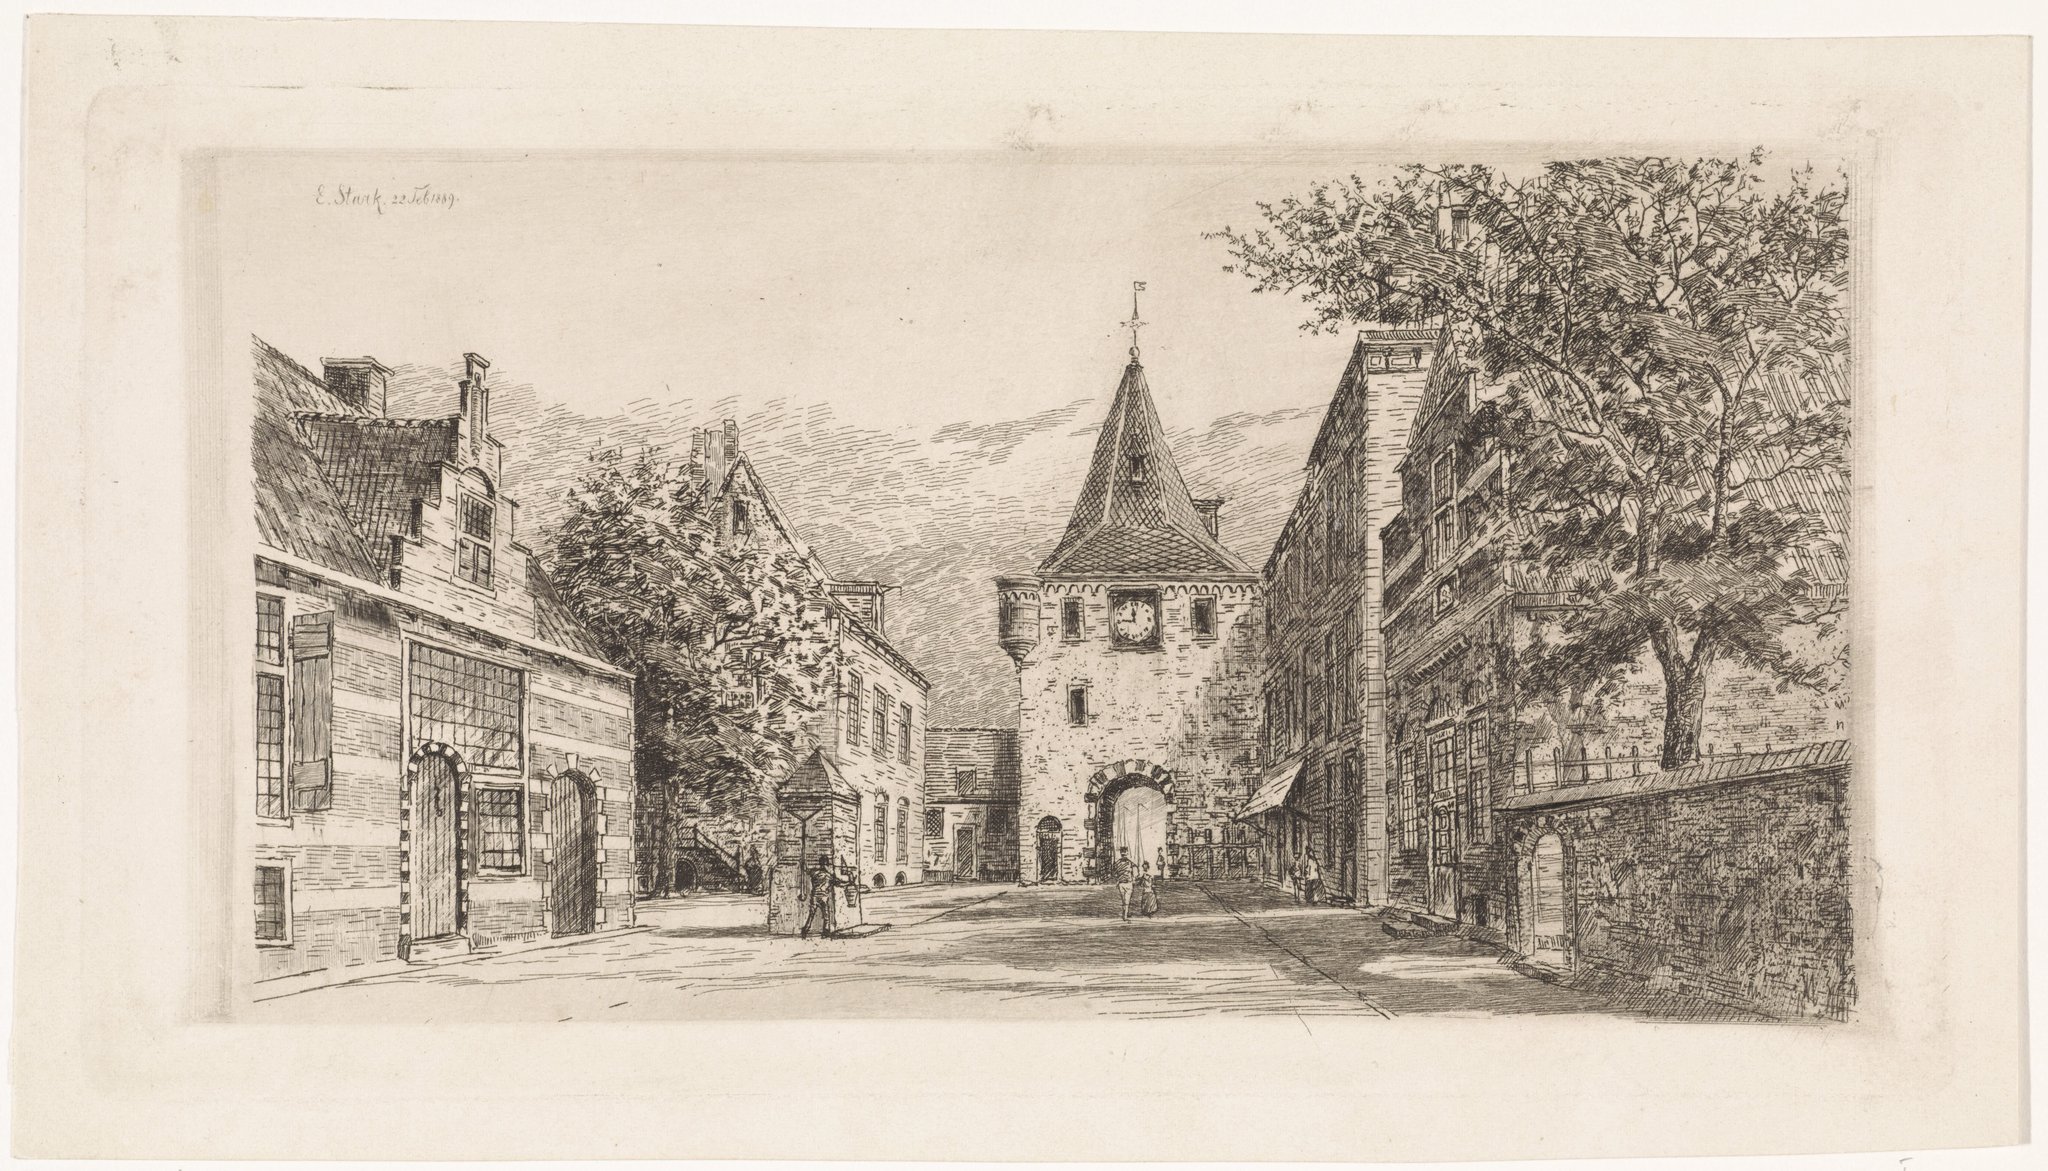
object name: print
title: Vischpoort te Elburg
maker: elias stark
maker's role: draughtsman, print maker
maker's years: 1849-1933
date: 1889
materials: paper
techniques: drypoint, etching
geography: nieuwer-amstel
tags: city-gate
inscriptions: collector's mark: Lugt 2228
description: Op verso een tekening in houtskool van twee zeilschepen aan het strand en figuren op de voorgrond.